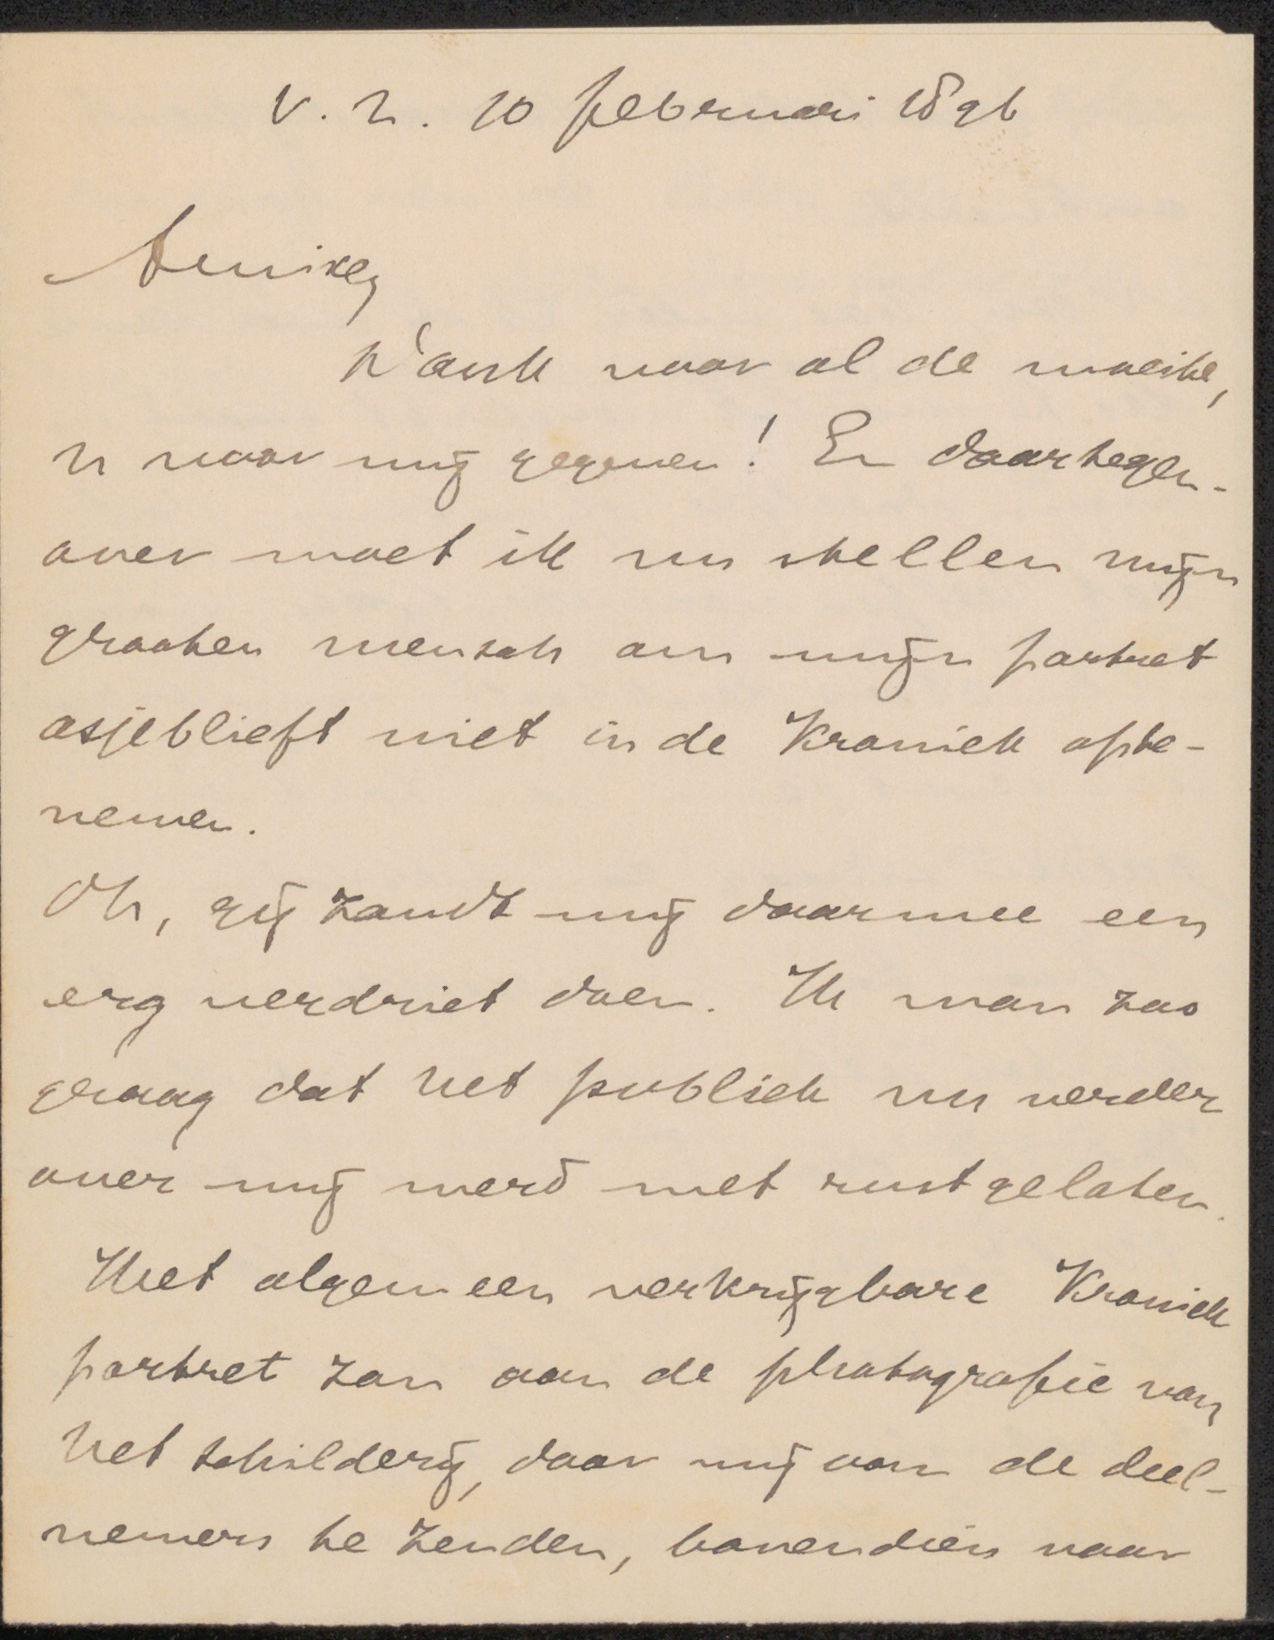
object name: letter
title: Brief aan Jan Veth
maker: jacob pieter moltzer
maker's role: jurist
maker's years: 1850-1907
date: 1896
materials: ink, paper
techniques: pen, writing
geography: the hague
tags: painter, draughtsman, designer, jan veth, photography, cinematography, the graphic arts, painting (including book-illumination, miniature-painting), historical persons (portraits and scenes from the life)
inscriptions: collector's mark: ‘RPK’